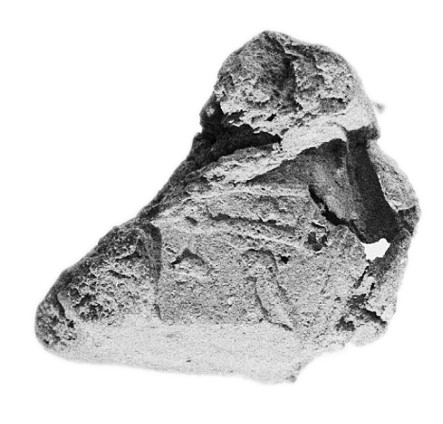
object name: sealing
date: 1981-1640 BCE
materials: mud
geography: egypt